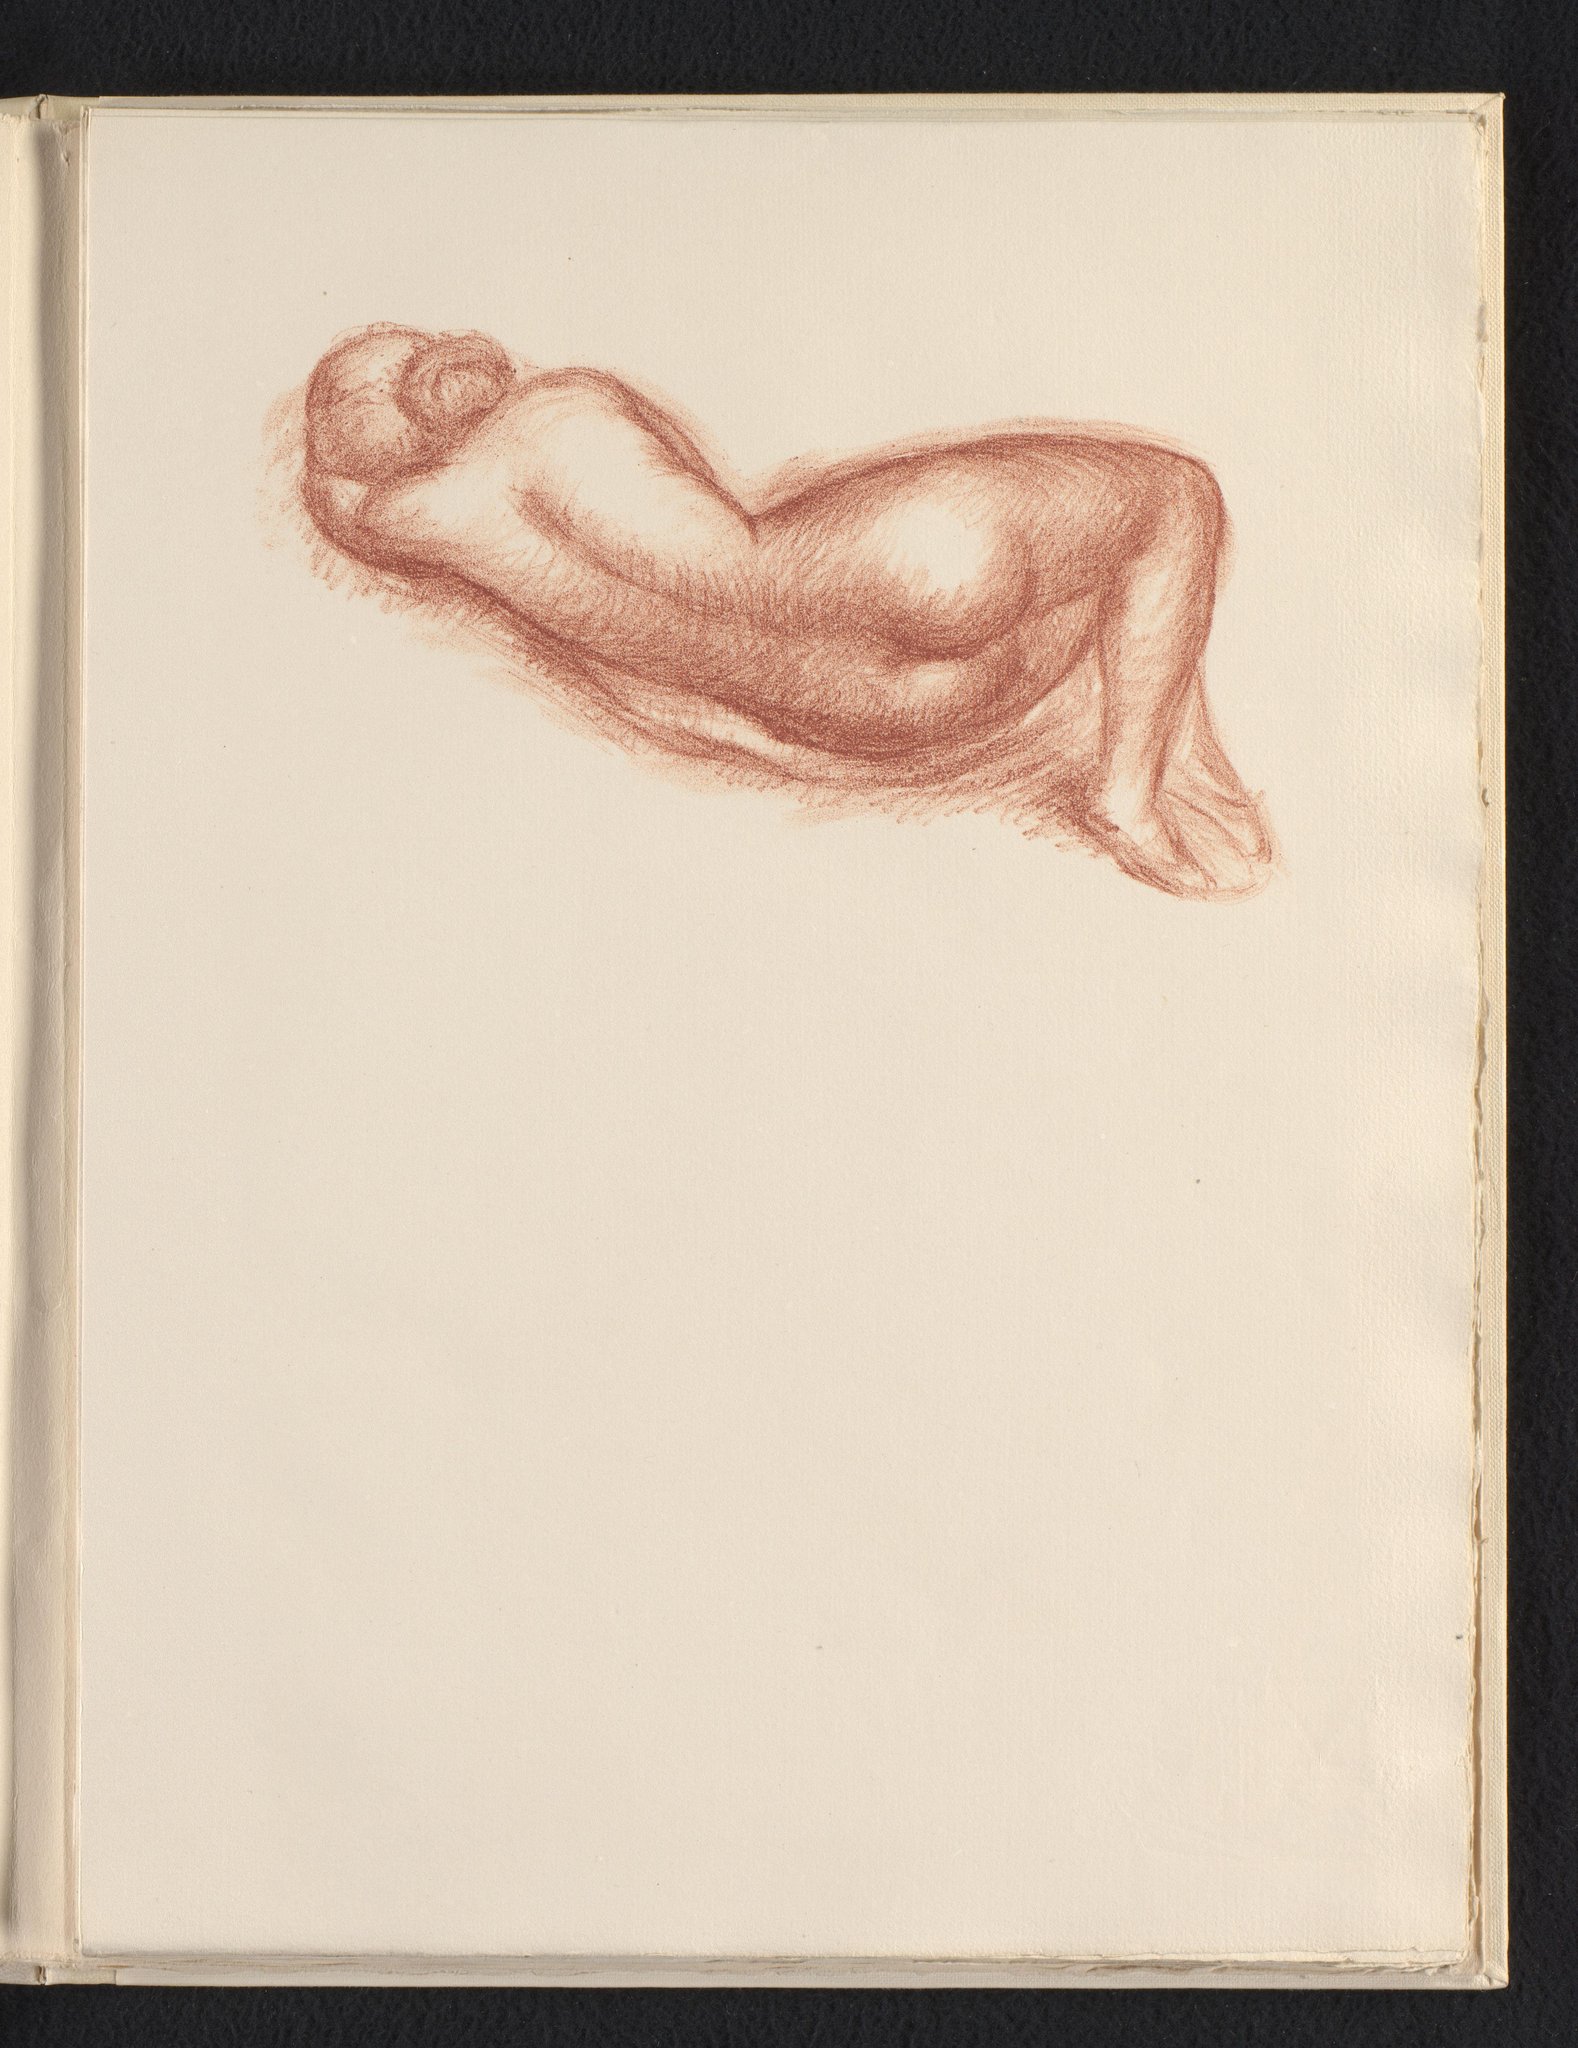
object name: book illustration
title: Op haar linkerzij liggende naakte vrouw, het hoofd op de arm rustend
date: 1948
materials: paper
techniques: lithograph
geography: paris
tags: lying on one side, stretched out - aa - female human figure, woman (showing herself) undressed, quasi-nude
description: Prent uit: Lucianus van Samosata. Dialogues des Courtisanes. [Vertaald uit het Grieks door] Charles Astruc. Parijs: s.n., 1948, deel van de suite met een extra afdruk van de prenten in sanguine.